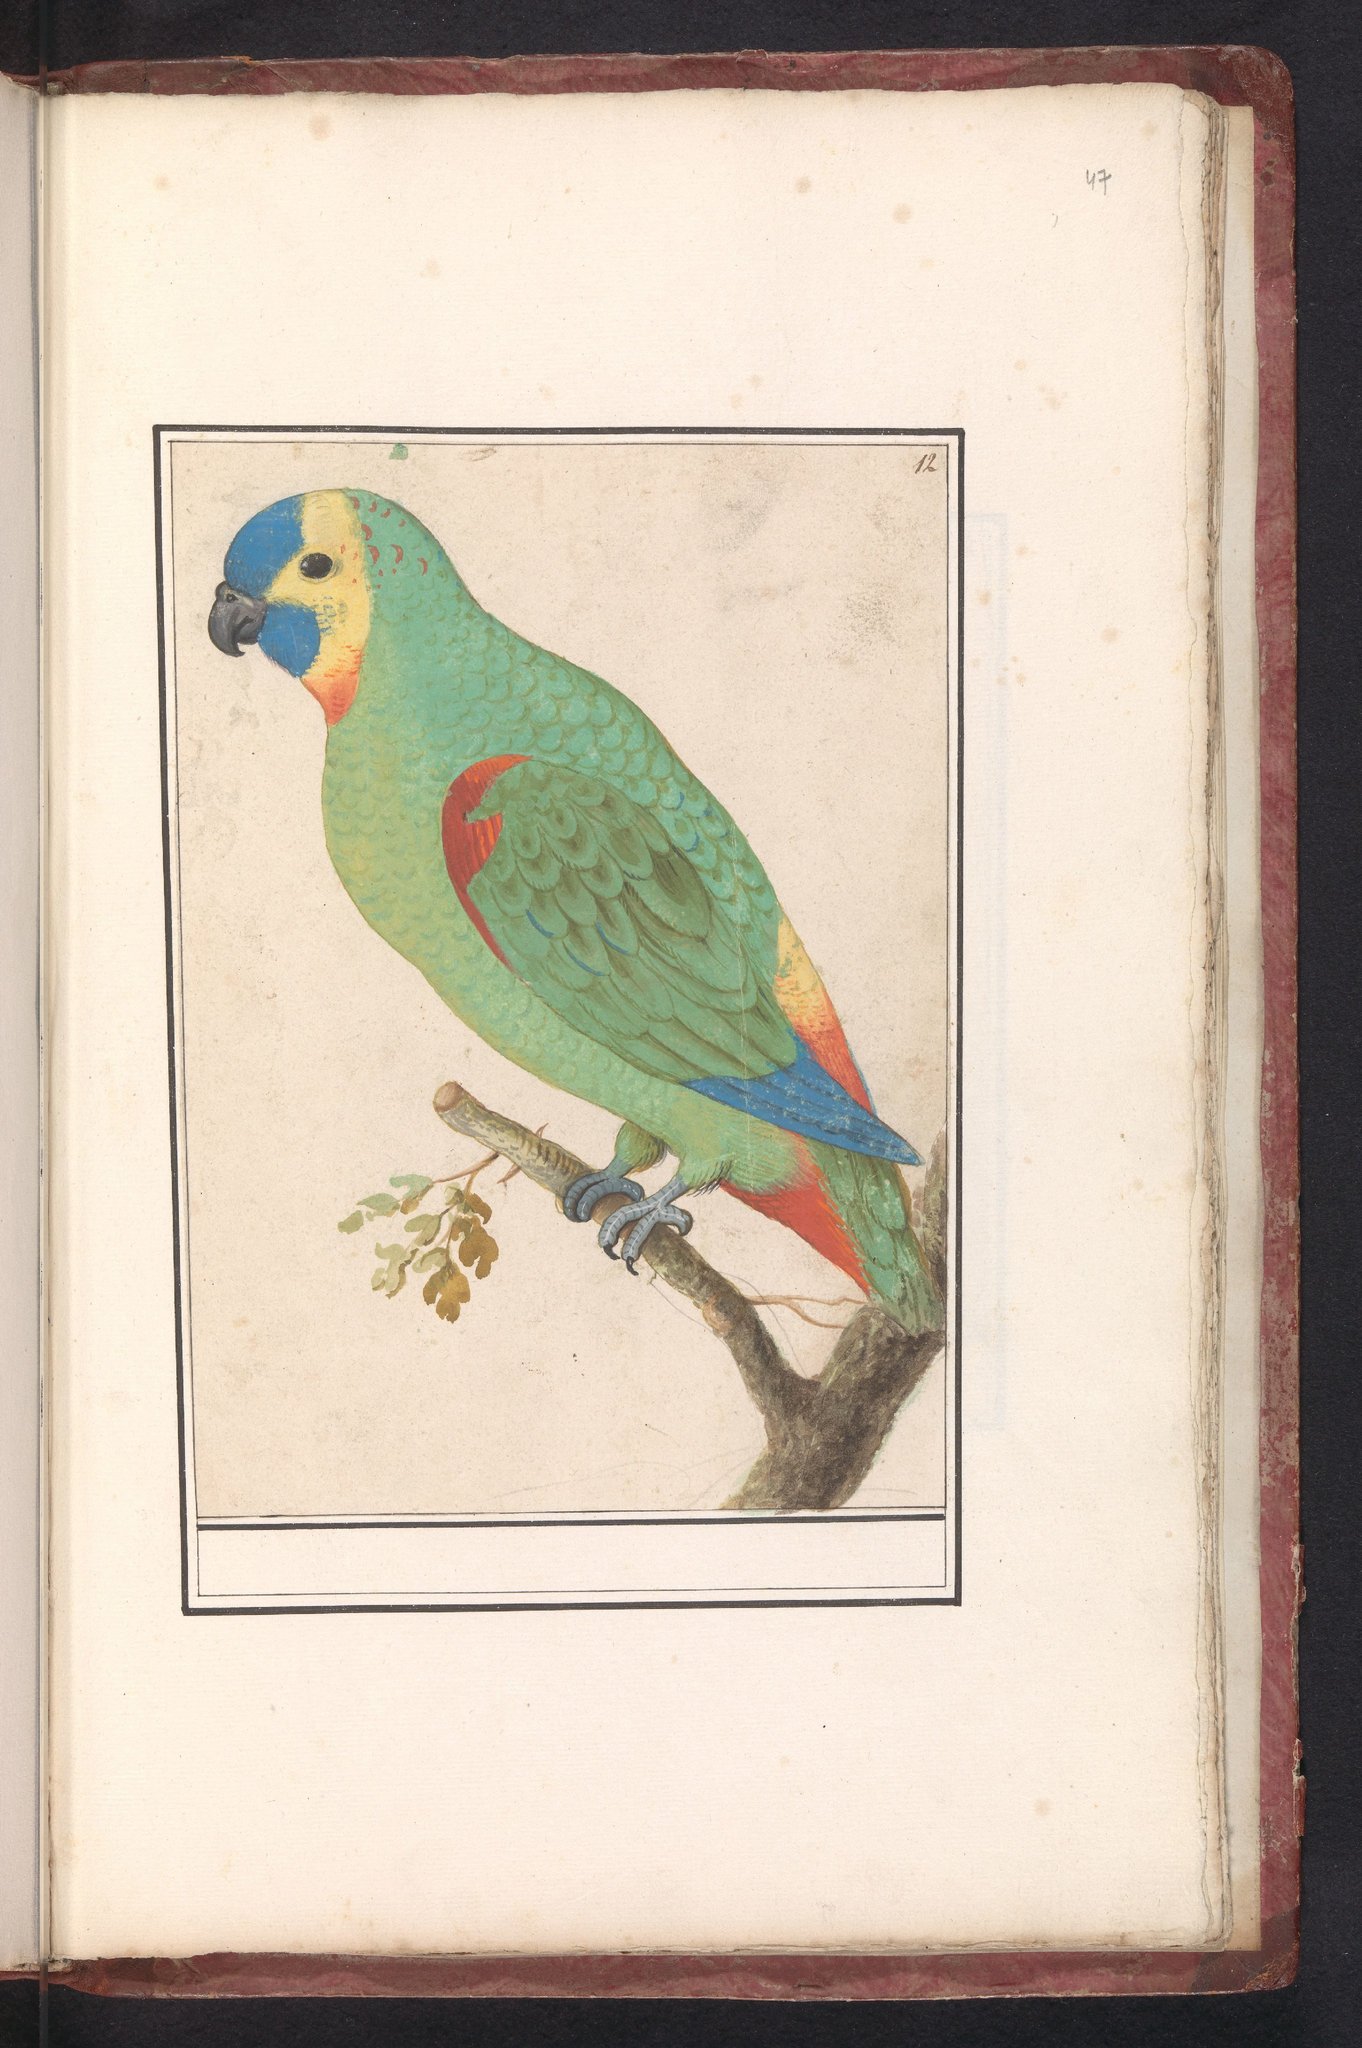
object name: drawing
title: Blauwvoorhoofdamazone (Amazona aestiva)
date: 1596-1610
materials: paint, paper, pencil, watercolor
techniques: brush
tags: ornamental birds: turquoise-fronted amazon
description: Blauwvoorhoofdamazone. Genummerd rechtsboven: 12. Onderdeel van het tweede album met tekeningen van vogels. Vierde van twaalf albums met tekeningen van dieren, vogels en planten bekend rond 1600, gemaakt in opdracht van keizer Rudolf II. Met toelichting in Nederlands, Latijn en Frans.